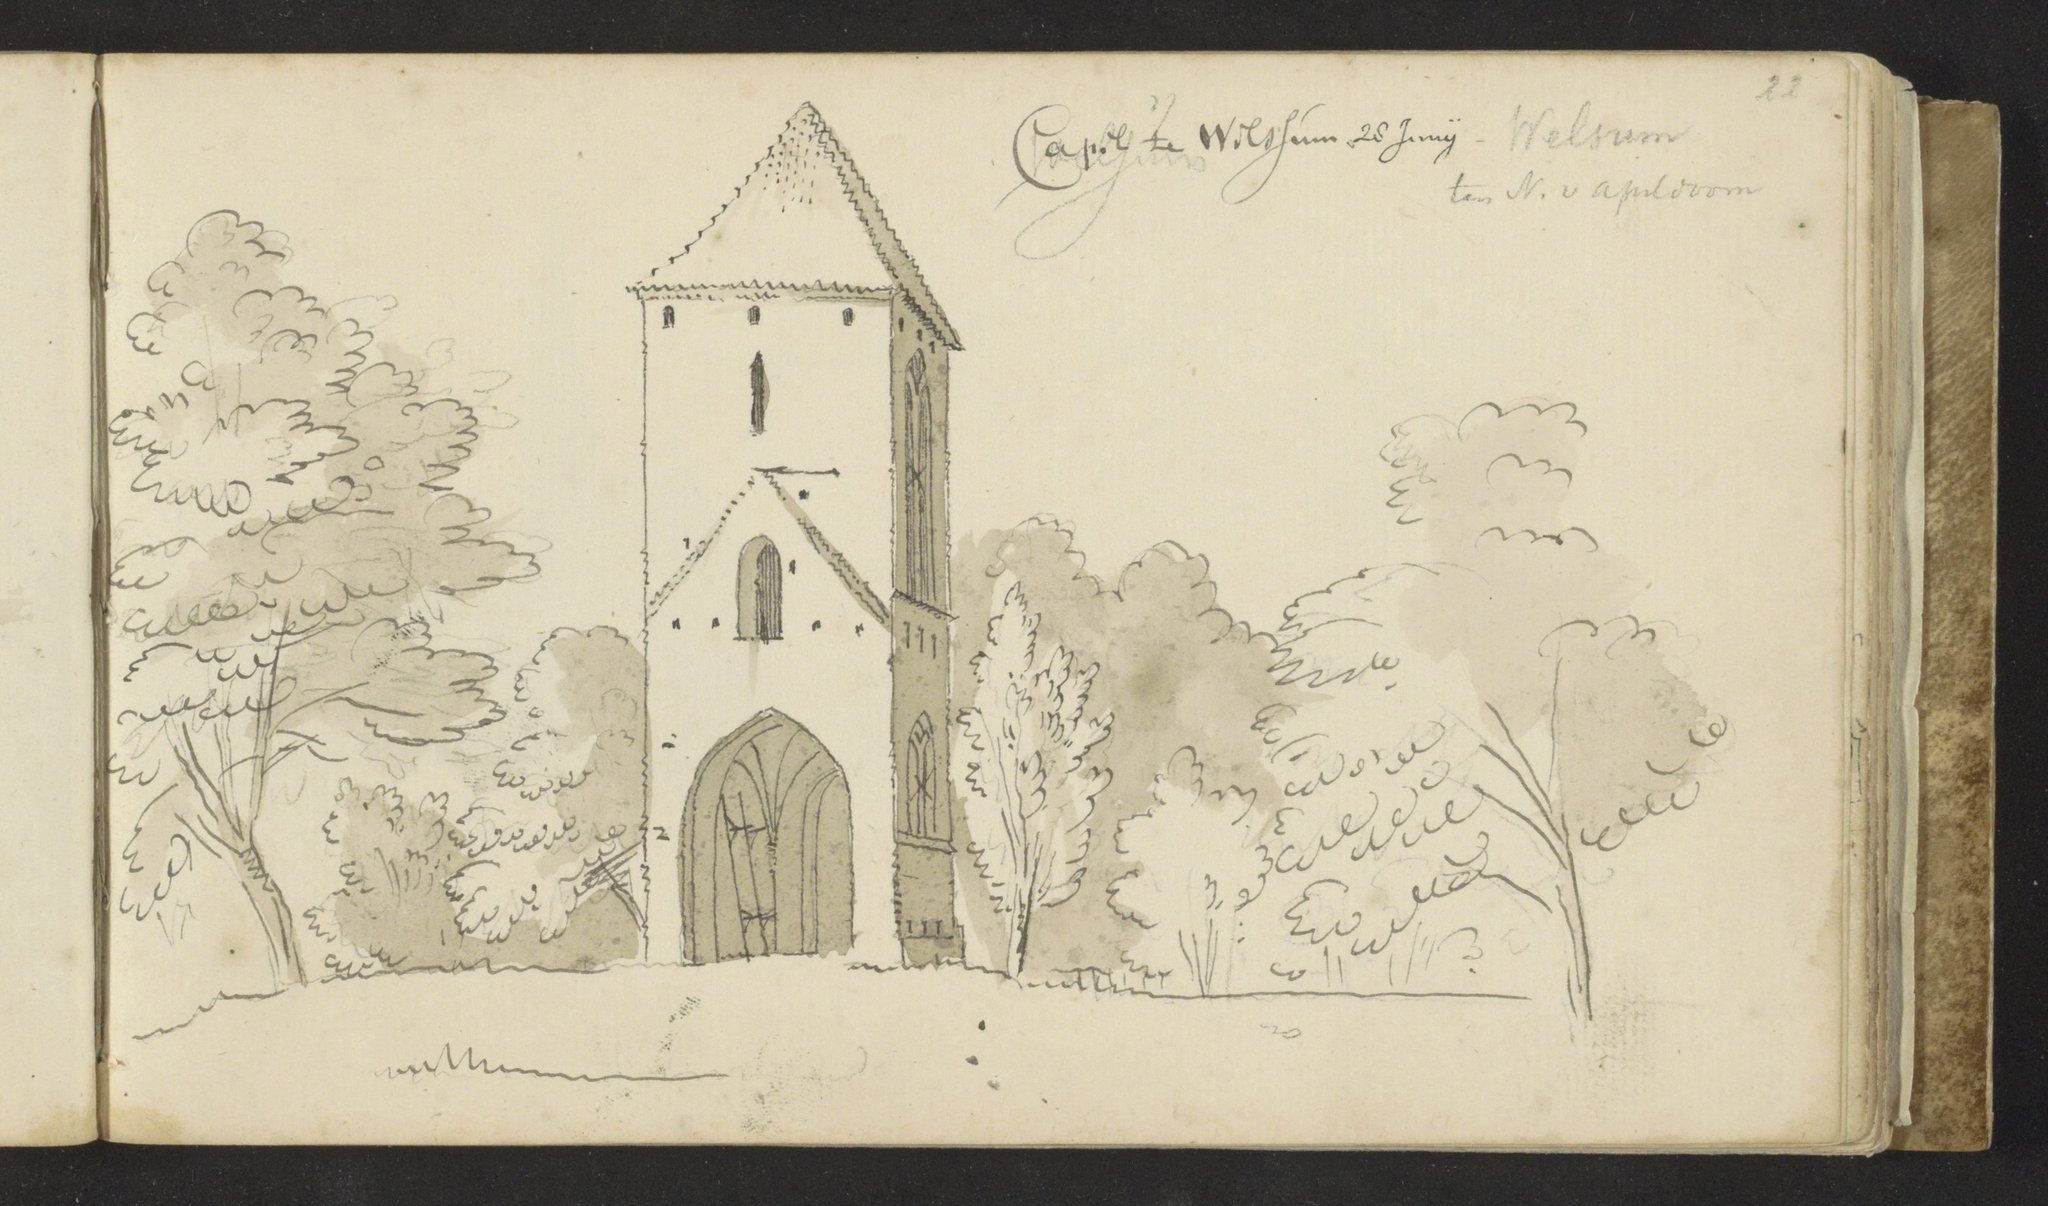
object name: sketchbook leaf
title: Kapel te Welsum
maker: abraham de haen (ii)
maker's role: draughtsman, print maker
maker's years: 1707-1748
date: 1732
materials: ink, paper, pencil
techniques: brush, pen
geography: welsum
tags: church (exterior)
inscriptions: annotation: ‘Capel te Welssum 28 junij’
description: Blad 22 recto uit een schetsboek met 51 bladen.